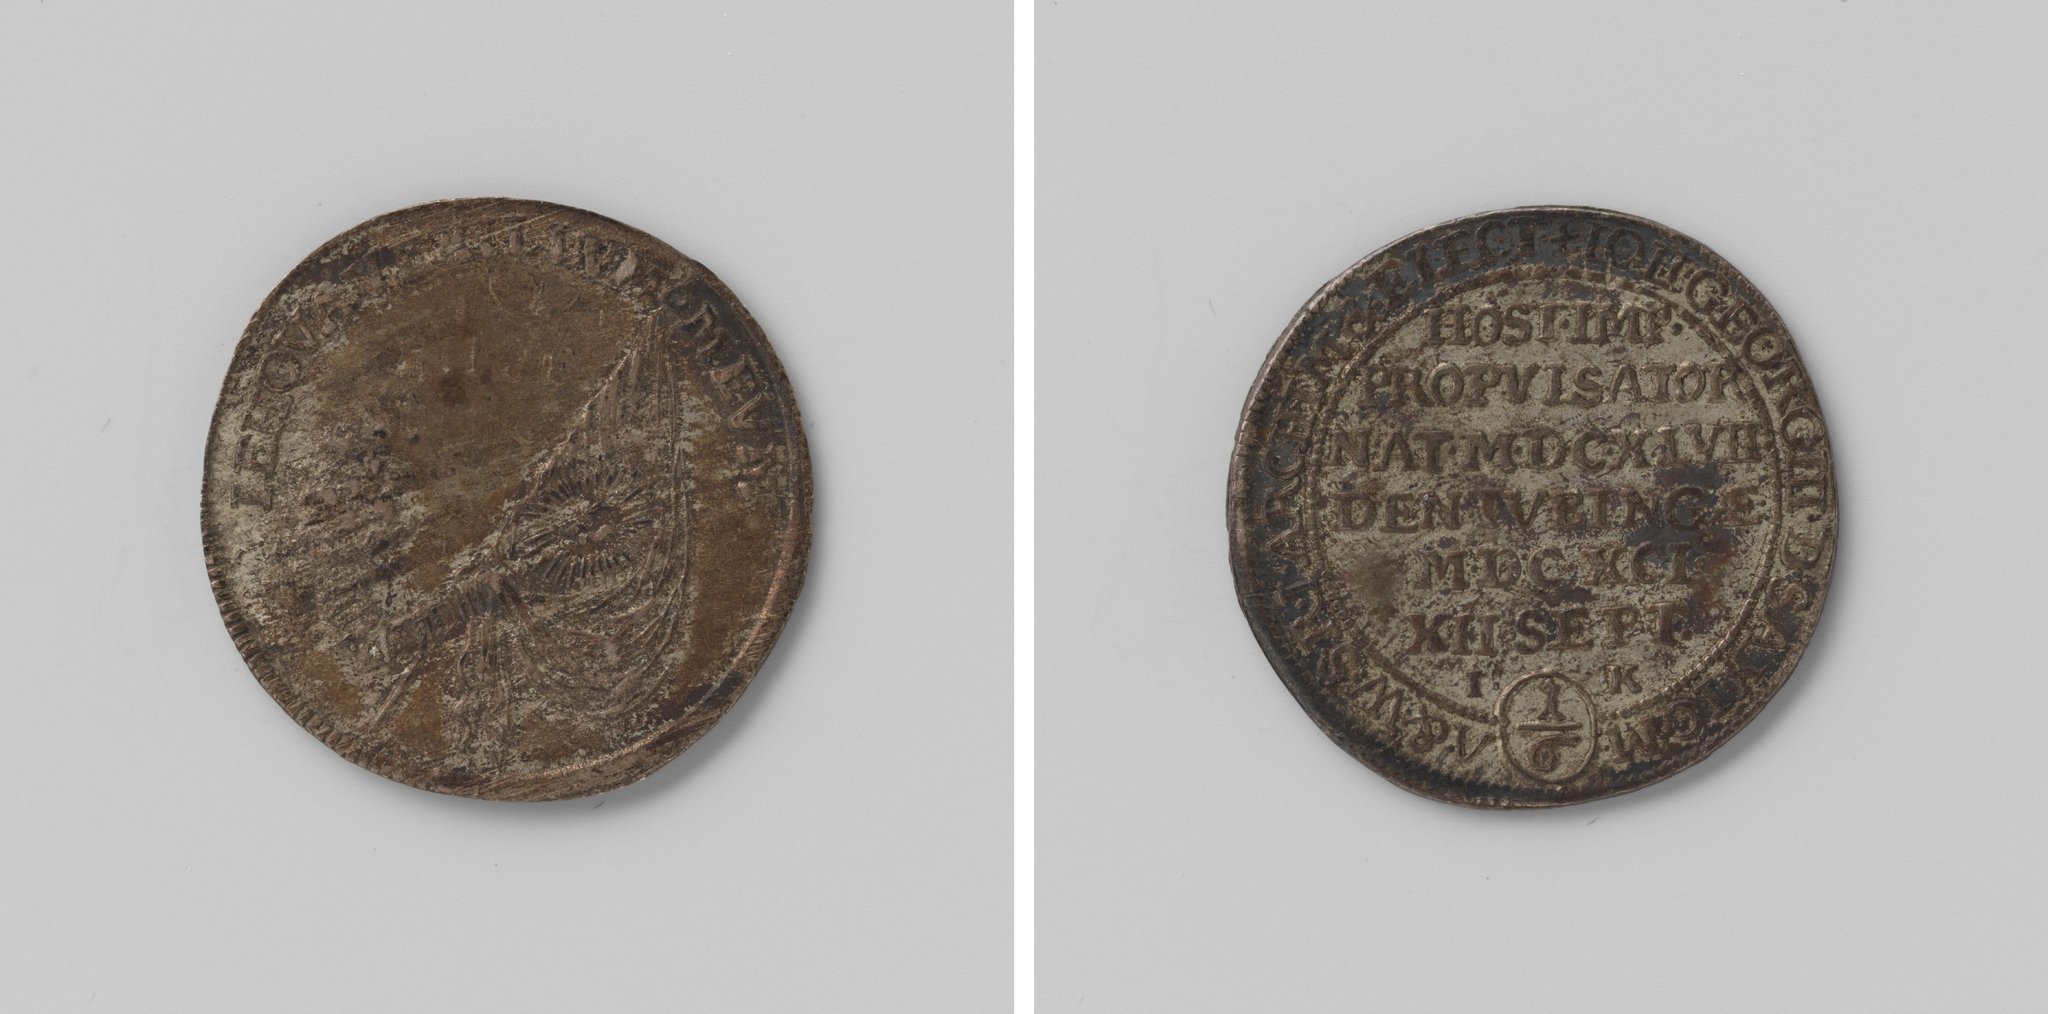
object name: history medal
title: Overlijden van Johan Georg III, keurvorst van Saksen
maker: johann kittel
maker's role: medailleur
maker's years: 1656-1740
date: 1691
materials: silver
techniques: striking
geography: wroclaw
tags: tübingen, keurvorst, keurvorst van saksen johan georg iii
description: Zilveren penning. Voorzijde: arm uit wolken met vlag waarop binnen stralenkrans de naam Jehovah staat binnen omschrift. Keerzijde: opschrift binnen omschrift